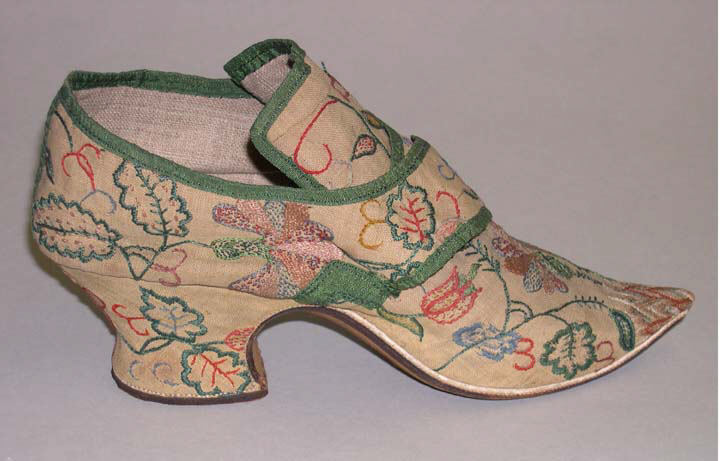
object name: shoe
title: Shoes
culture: british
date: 1700-1725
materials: silk